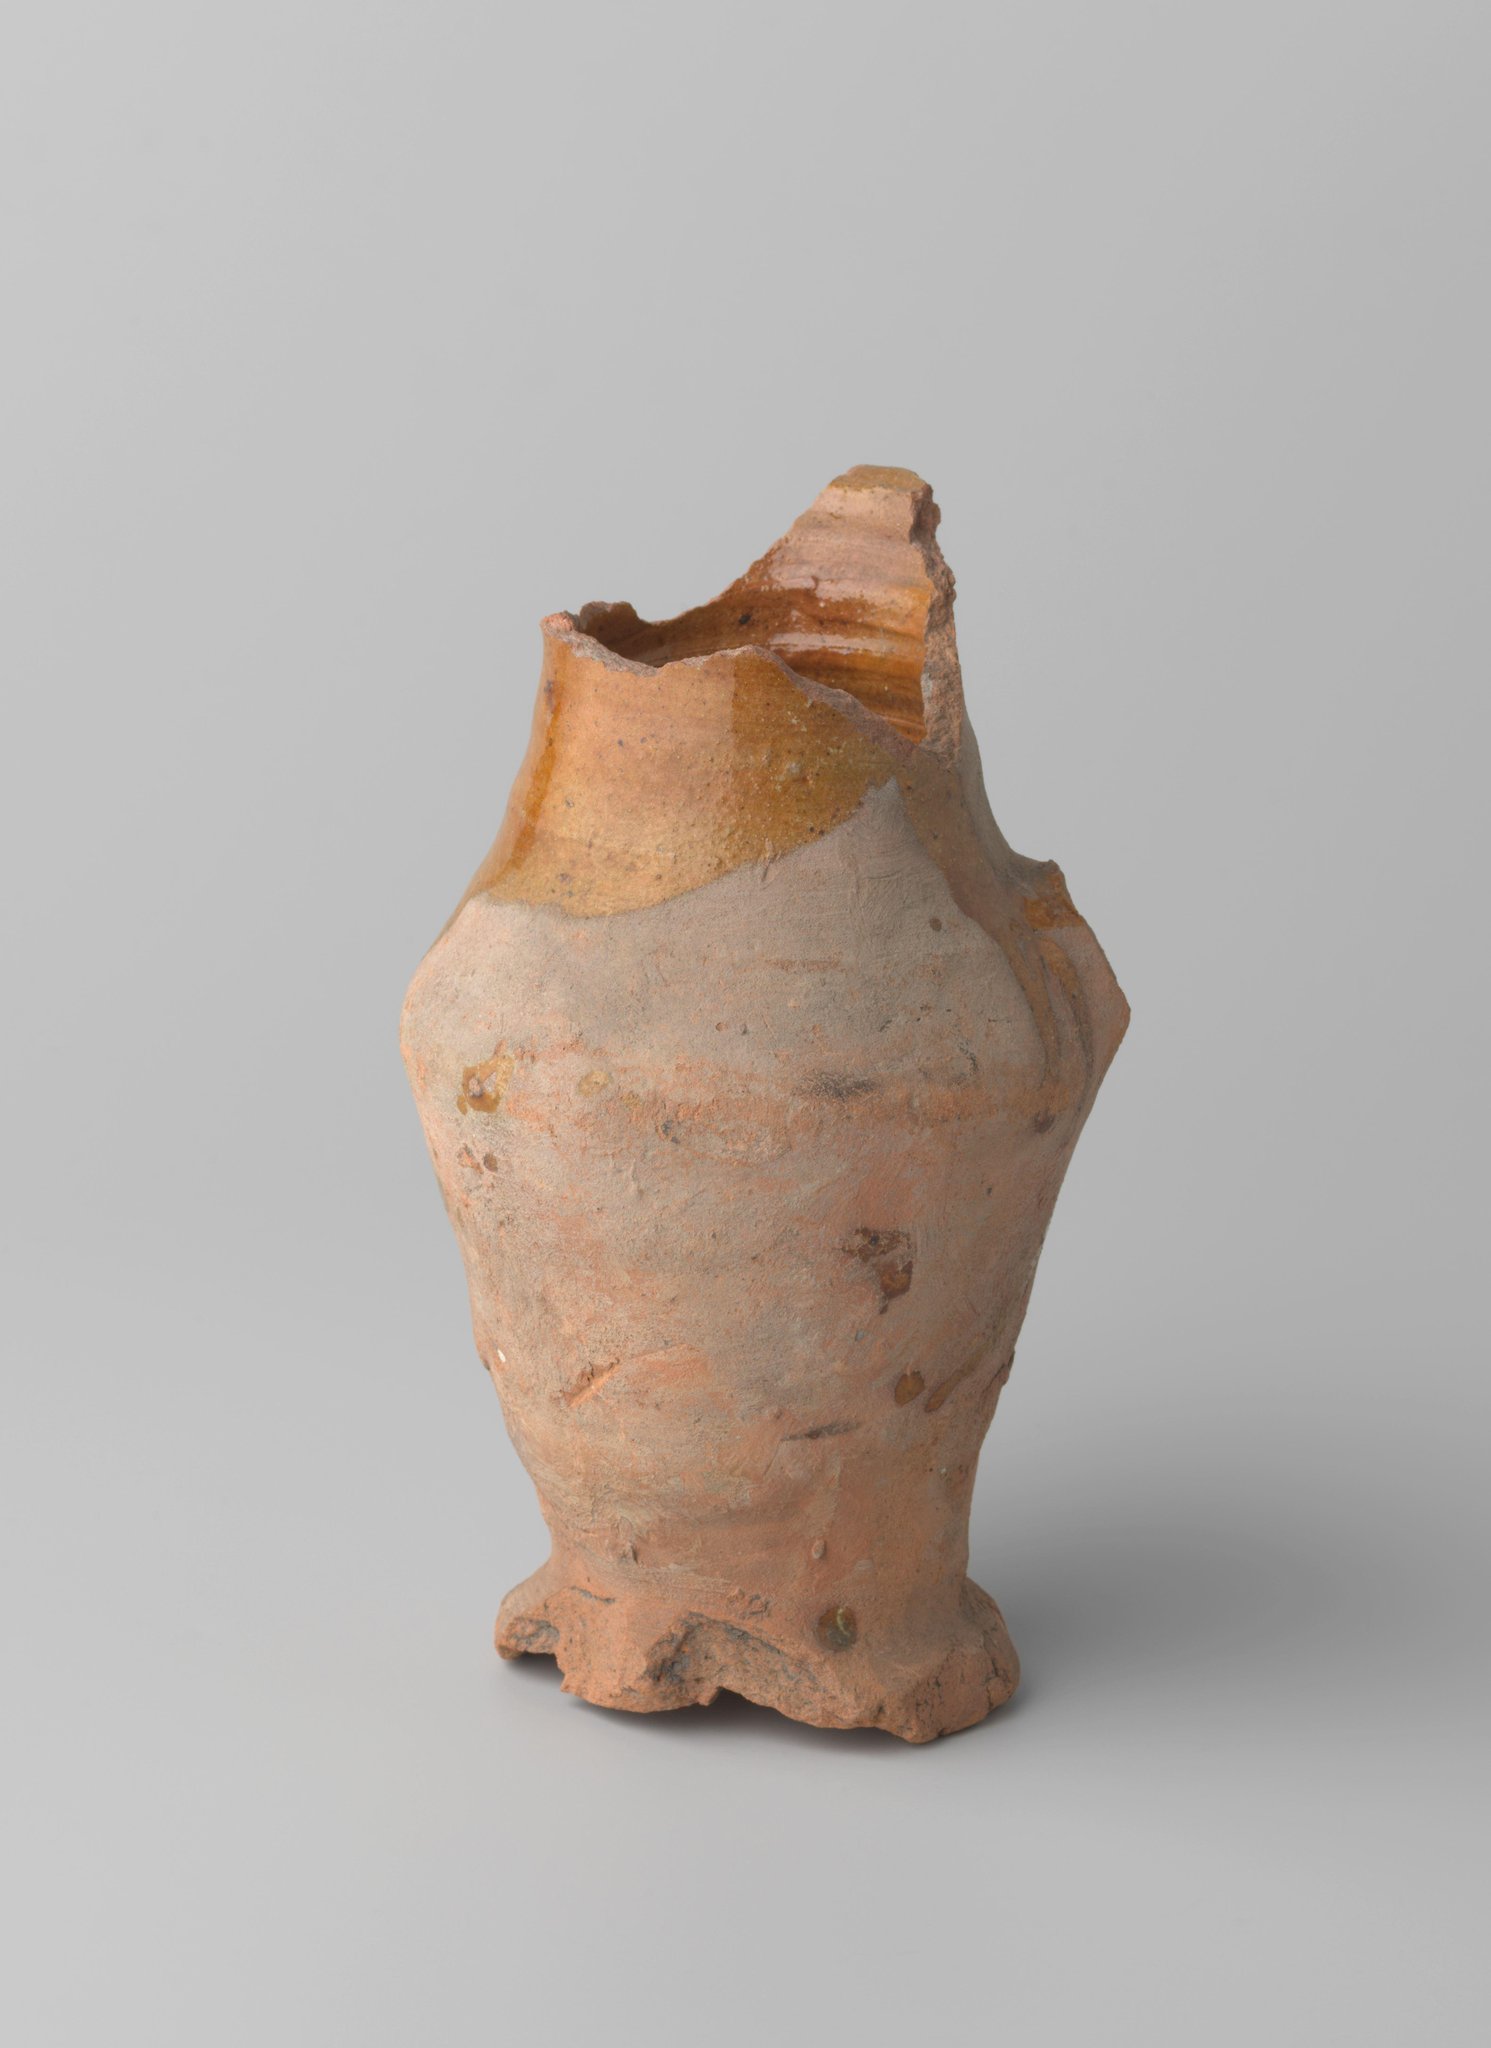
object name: ewer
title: Kan van roodbakkend aardewerk, aan de binnen-en deels de buitenzijde voorzien van glazuur, met beschadigde rand, voet en oor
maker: Anonymous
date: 1500-1799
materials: earthenware, glaze